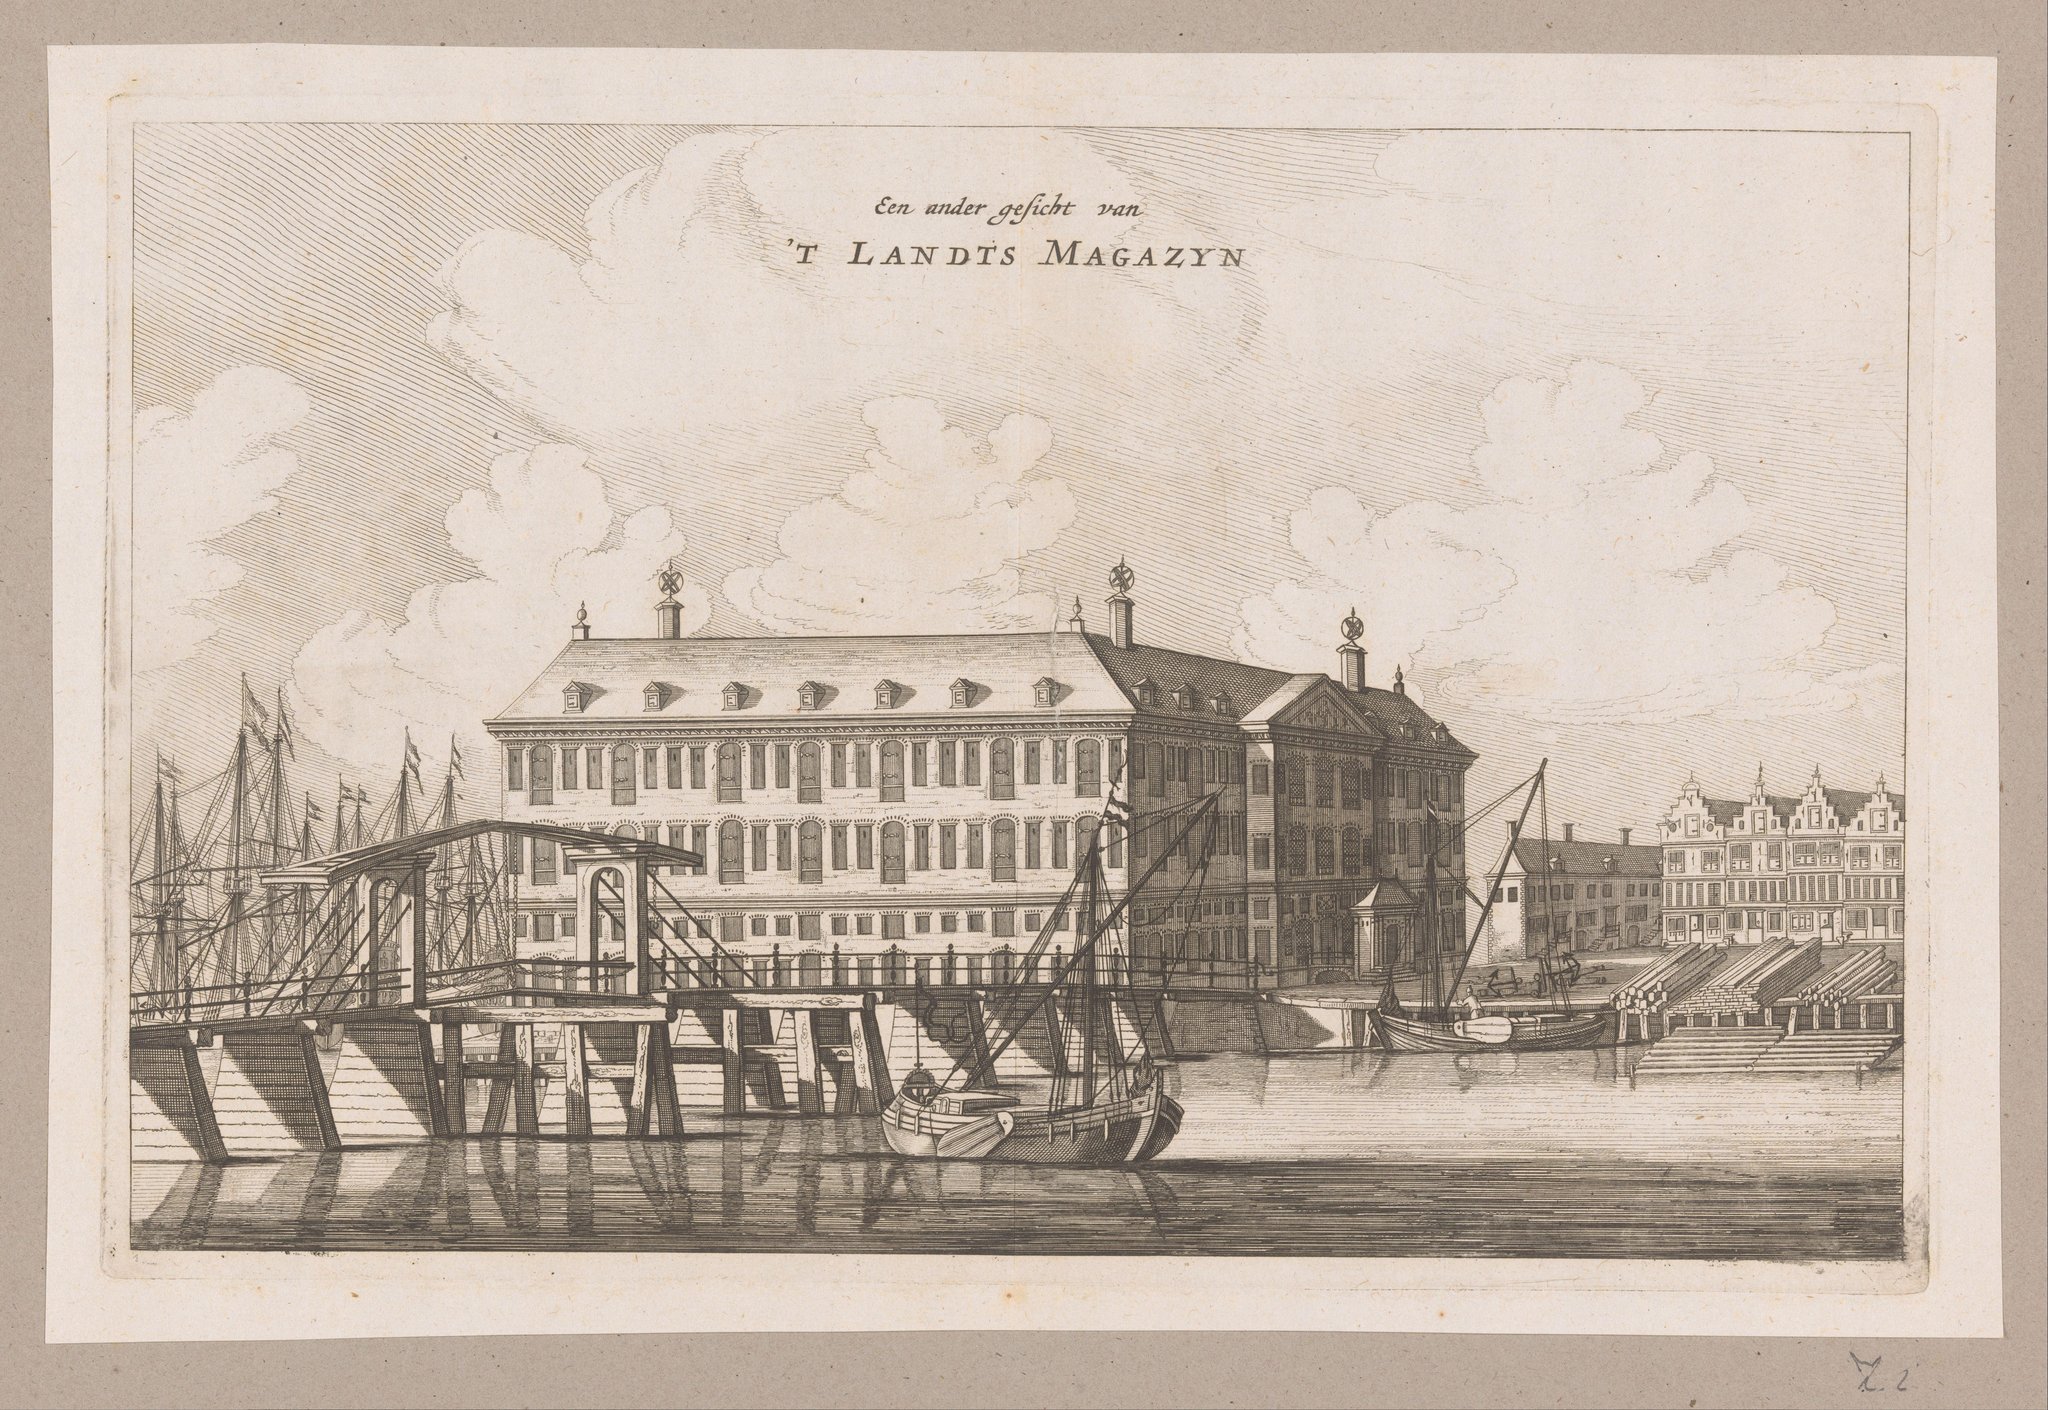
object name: print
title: Gezicht op 's Lands Zeemagazijn (Admiraliteitsmagazijn) te Amsterdam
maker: Anonymous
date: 1663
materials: paper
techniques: etching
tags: pier, quay, wharf, civic architecture; edifices; dwellings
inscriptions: watermark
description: Prent verschenen in: Dapper, Olfert. Historische beschryving der stadt Amsterdam: waer in de voornaemste geschiedenissen (na een kort verhael van gansch Hollant en d'omleggende dorpen (…). Amsterdam: Jacob van Meurs, 1663.* En in: Zesen, Philipp von. Beschreibung der Stadt Amsterdam: darinnen von derselben ersten Ursprunge bis auf gegenwärtigen Zustand (…). Amsterdam: Joachim Nosche, 1664. * In sommige exemplaren van deze uitgave komt de huidige staat van de prent voor. In andere exemplaren is een latere staat ingebonden, waarop boven de Nederlandse een Franse titel is toegevoegd.